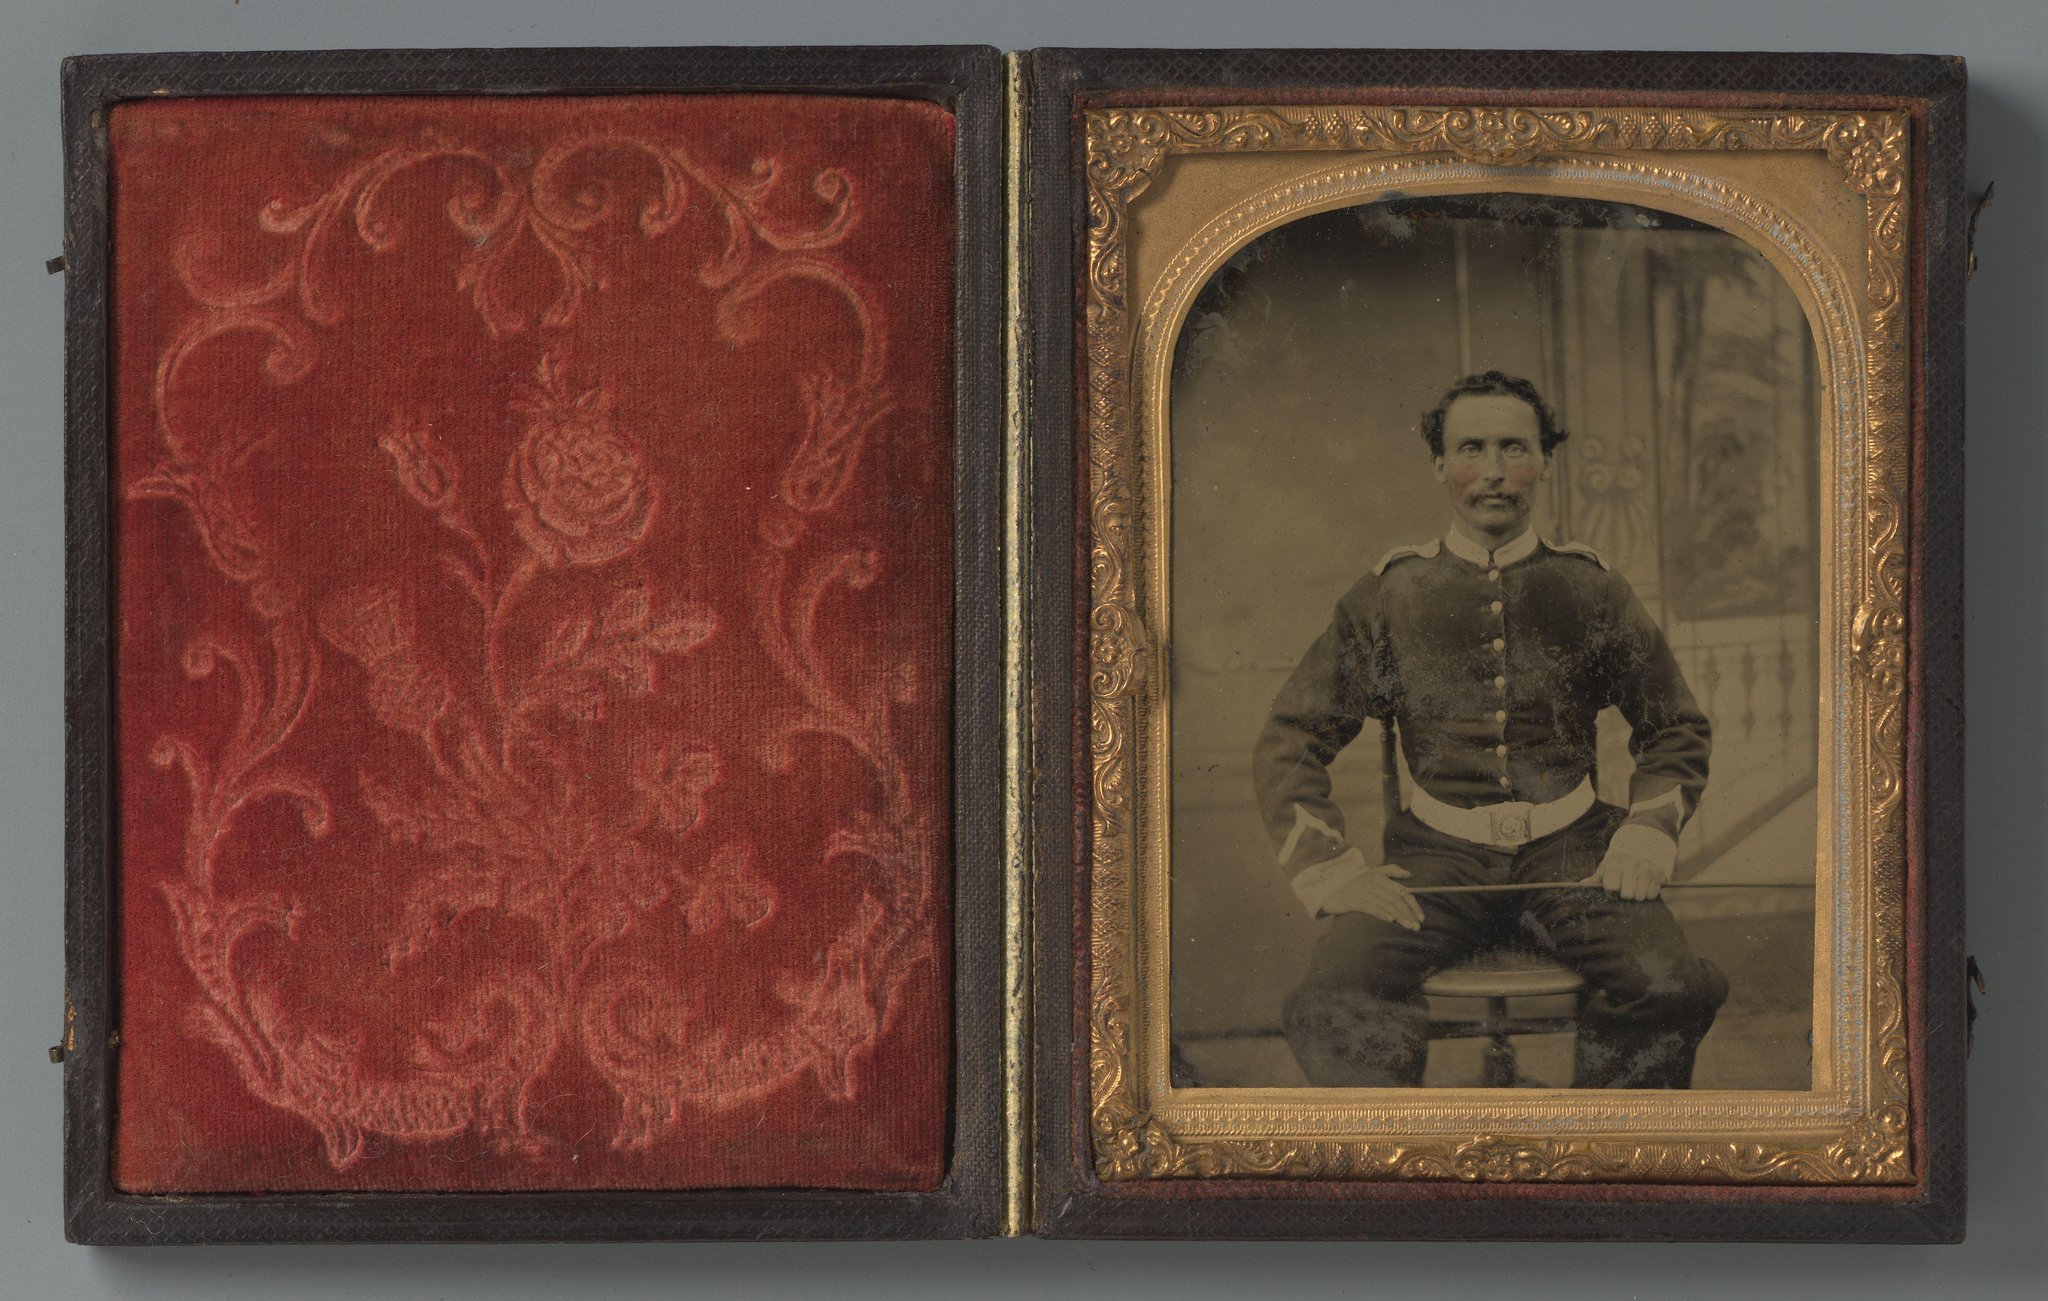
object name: photograph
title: Portret van een onbekende zittende soldaat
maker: Anonymous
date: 1855-1870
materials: glass, metal, paper, velvet, wood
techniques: ambrotype, hand coloring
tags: sitting figure, private soldier, historical persons